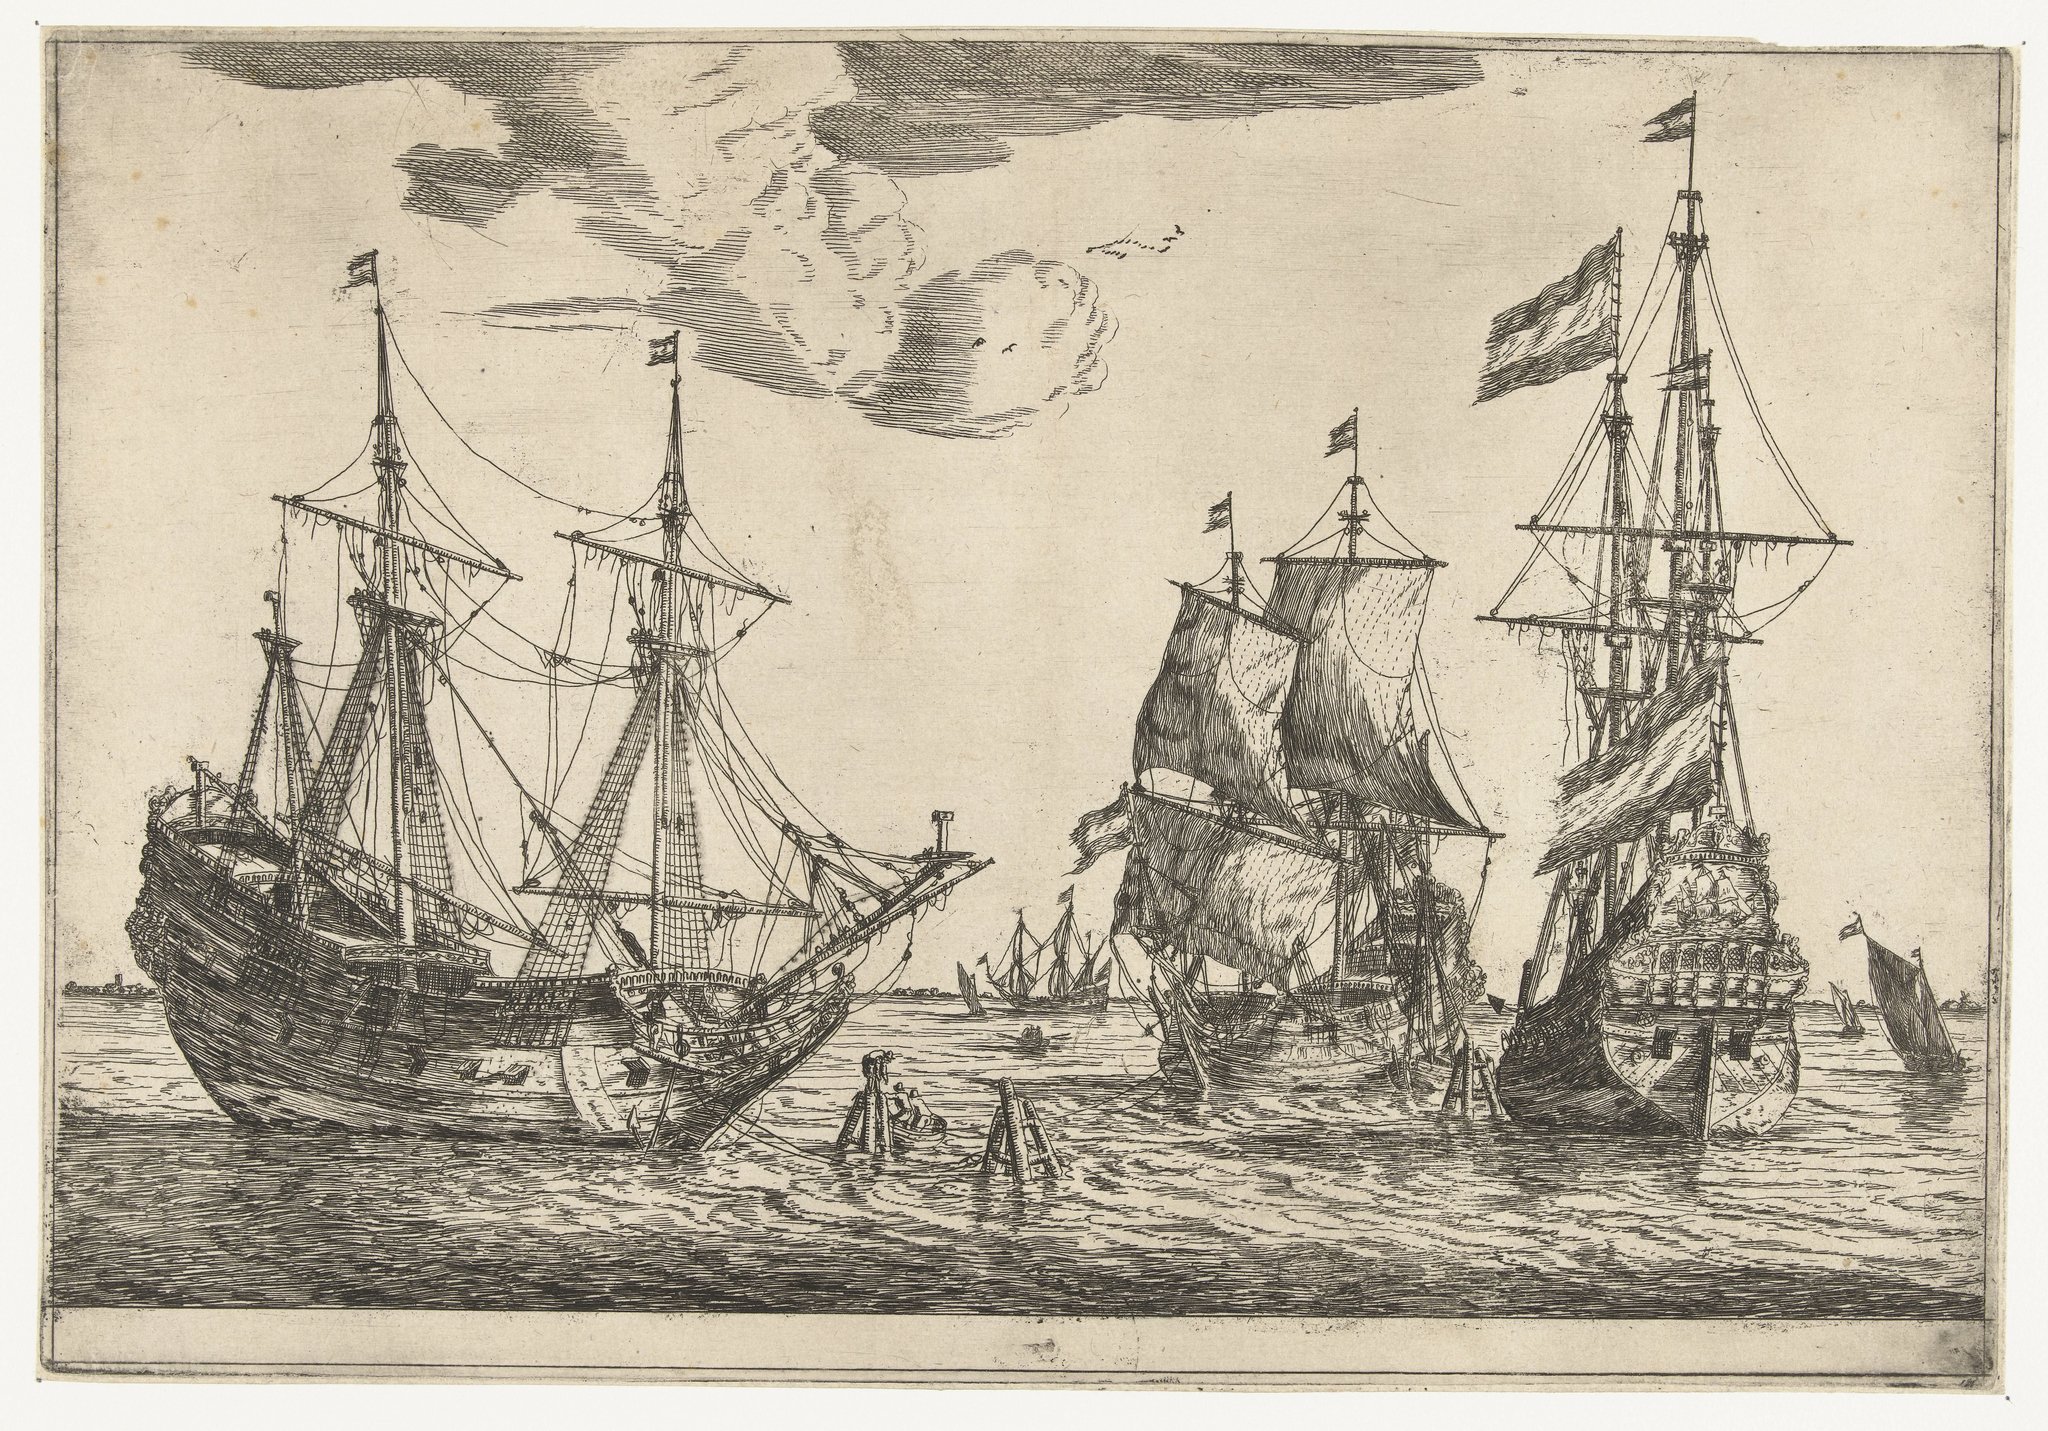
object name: print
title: Drie aangemeerde zeilschepen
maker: reinier nooms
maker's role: draughtsman, painter, print maker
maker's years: 1623-1664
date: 1650-1664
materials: paper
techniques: etching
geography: netherlands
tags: sailing-ship, sailing-boat, mooring-buoy, bollard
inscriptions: collector's mark: Lugt 2228a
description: Drie grote zeilschepen, vastgelegd met touwen aan drie meerpalen in het water.